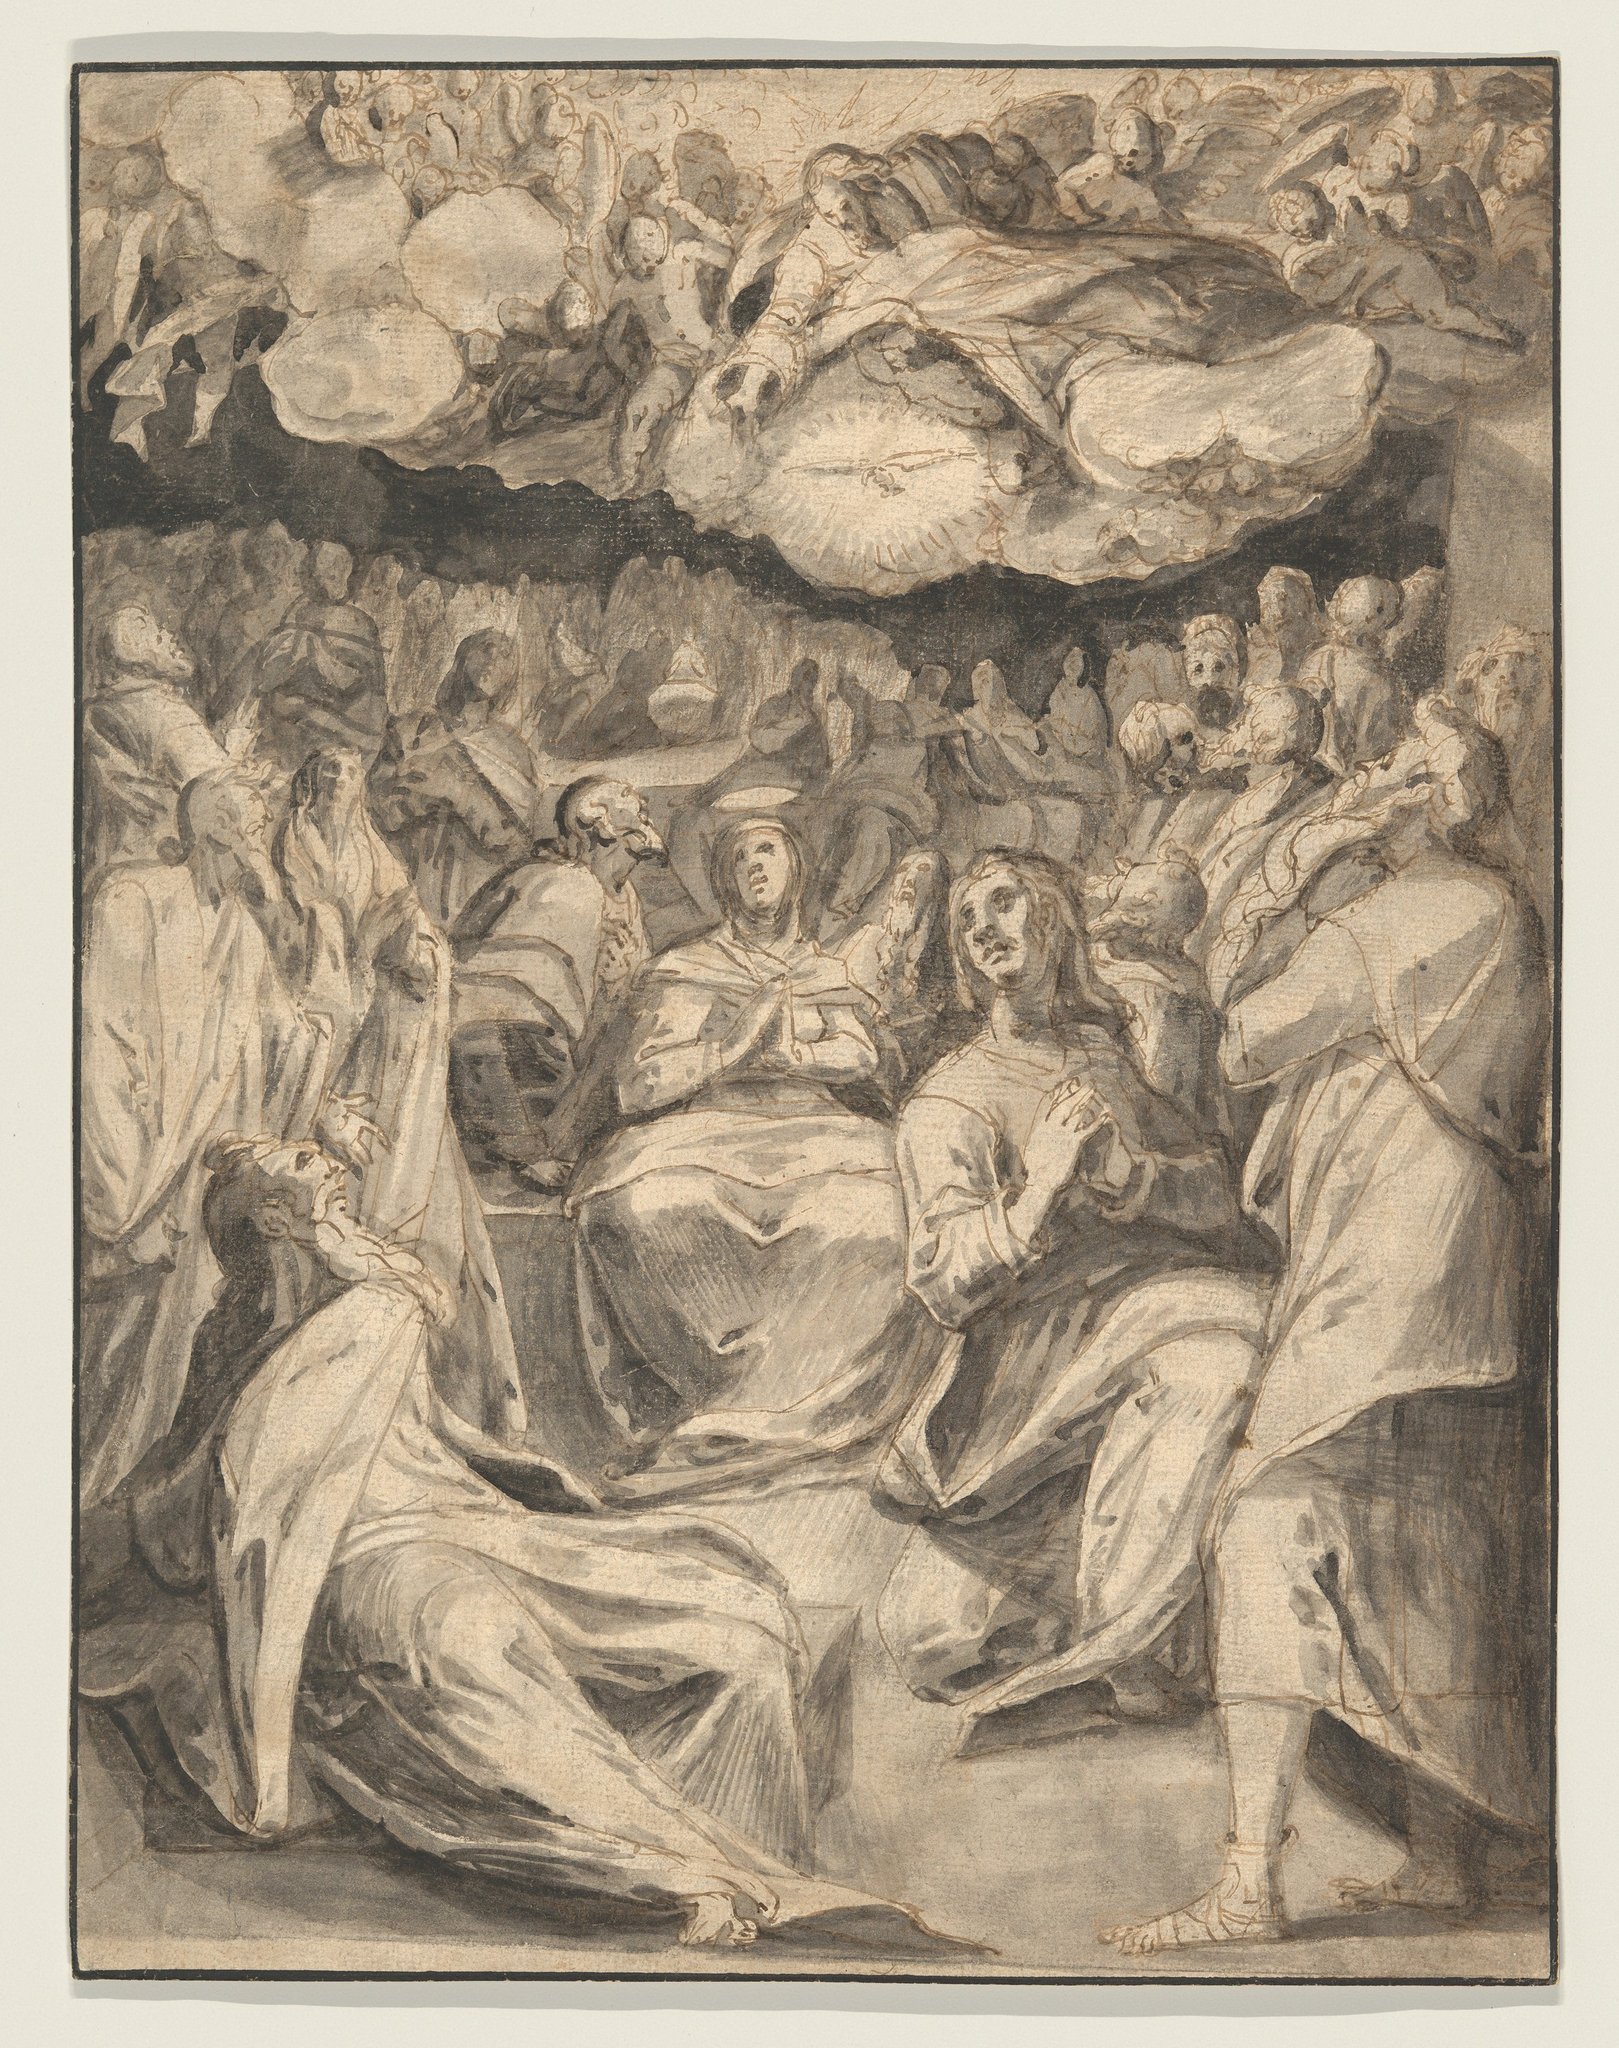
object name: drawing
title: The Pentecost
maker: master of the egmont albums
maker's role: artist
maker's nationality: netherlandish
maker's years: 16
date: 1501-1600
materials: ink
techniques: brush, pen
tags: pentecost,crowd